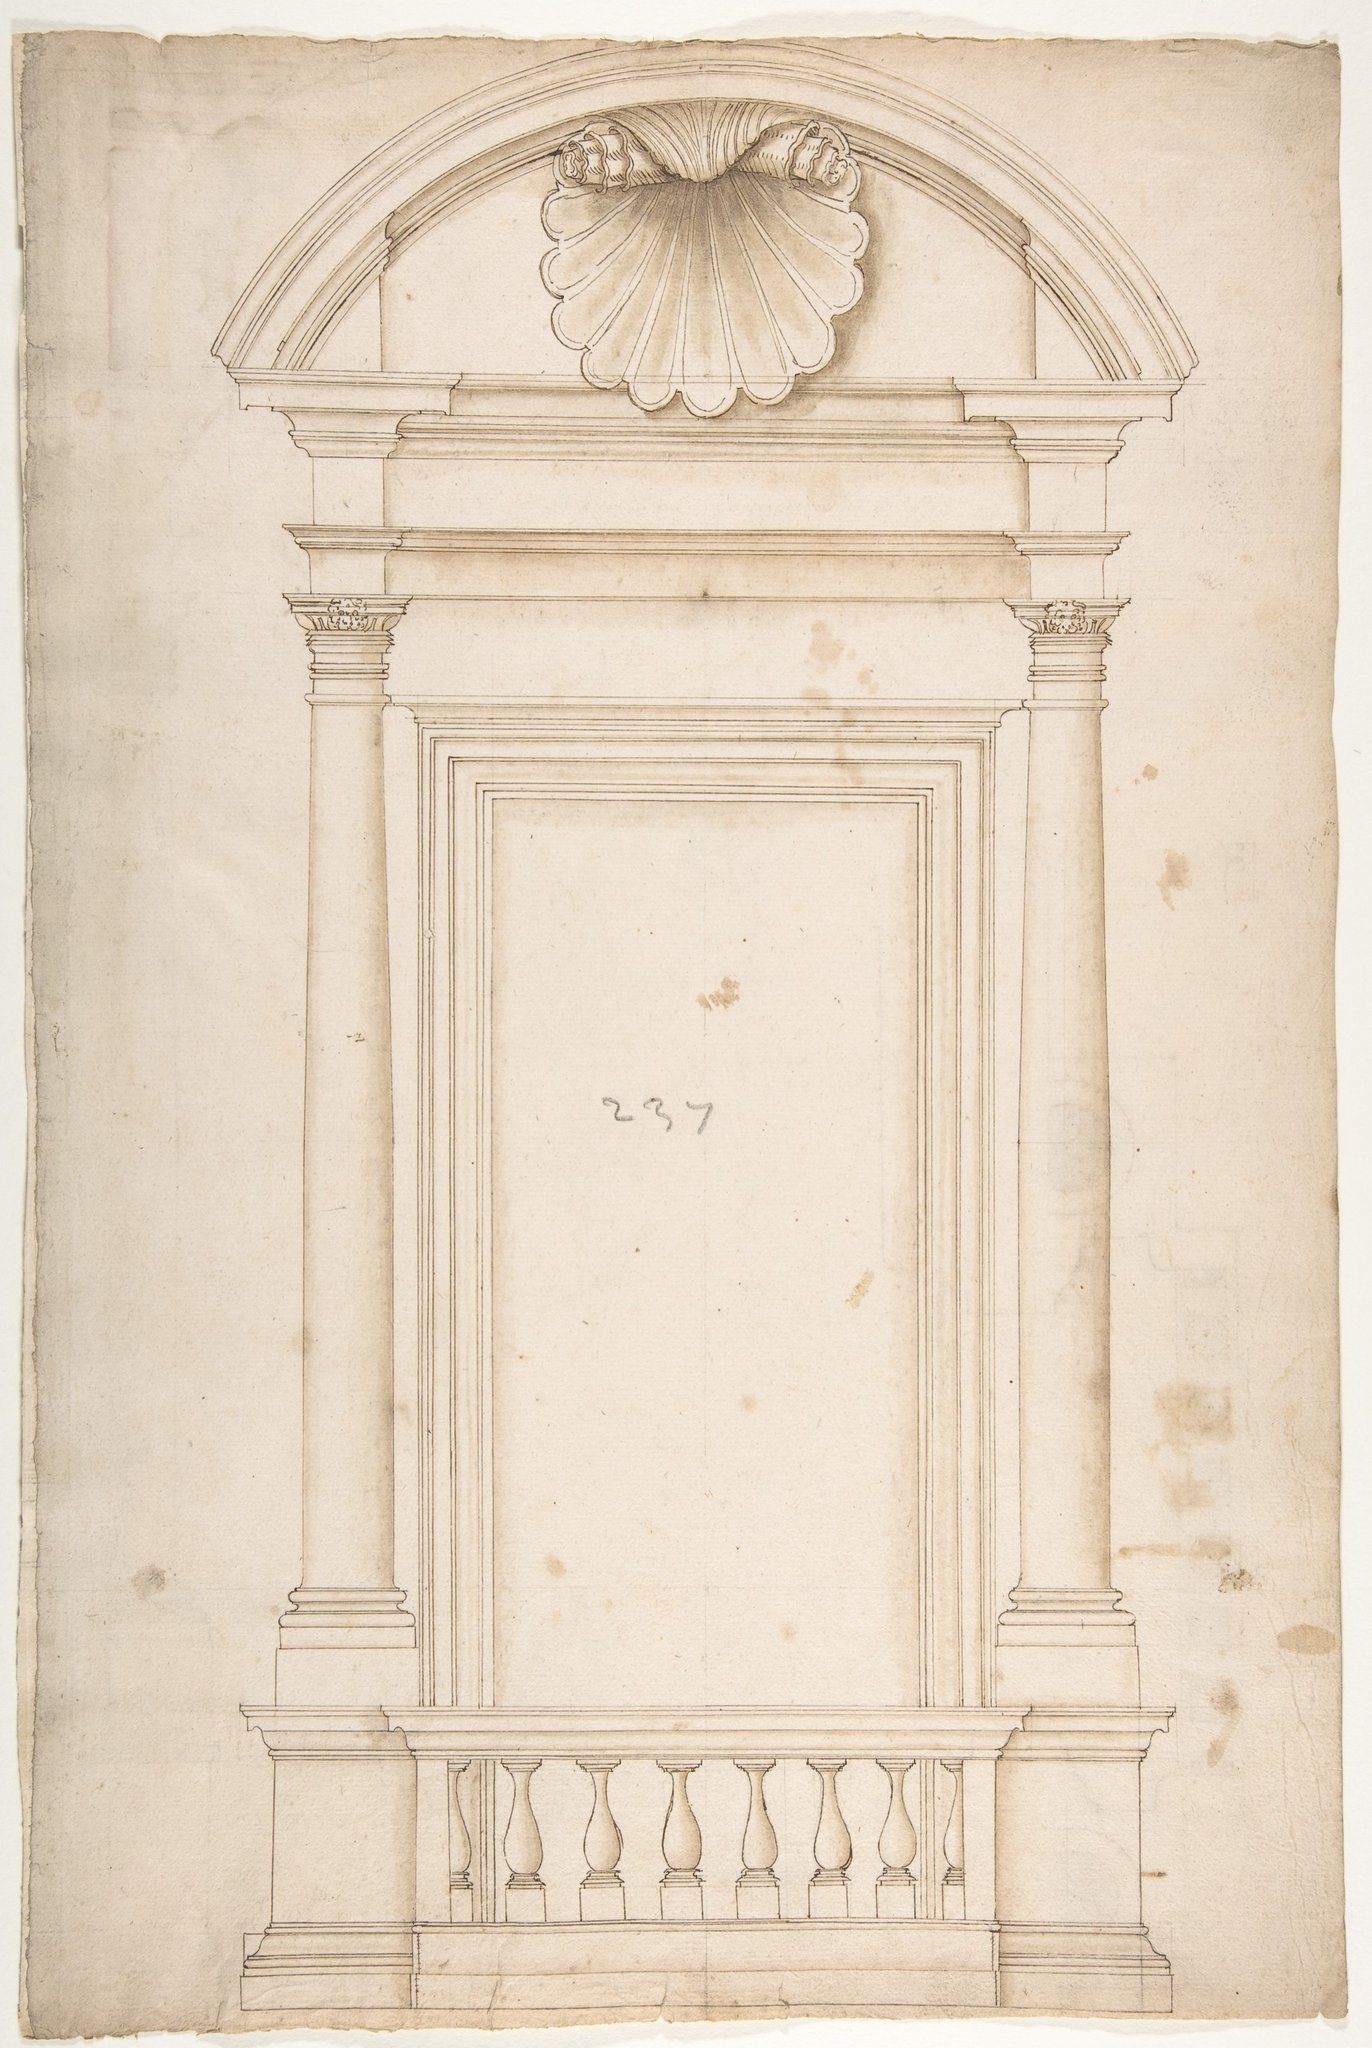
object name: drawing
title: Palazzo Senatorio, window, elevation (recto) Palazzo Senatorio, window, plan; section (verso)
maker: anonymous, french, 16th century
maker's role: draftsman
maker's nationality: french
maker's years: 1500-1600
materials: chalk, ink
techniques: incising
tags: architecture,windows